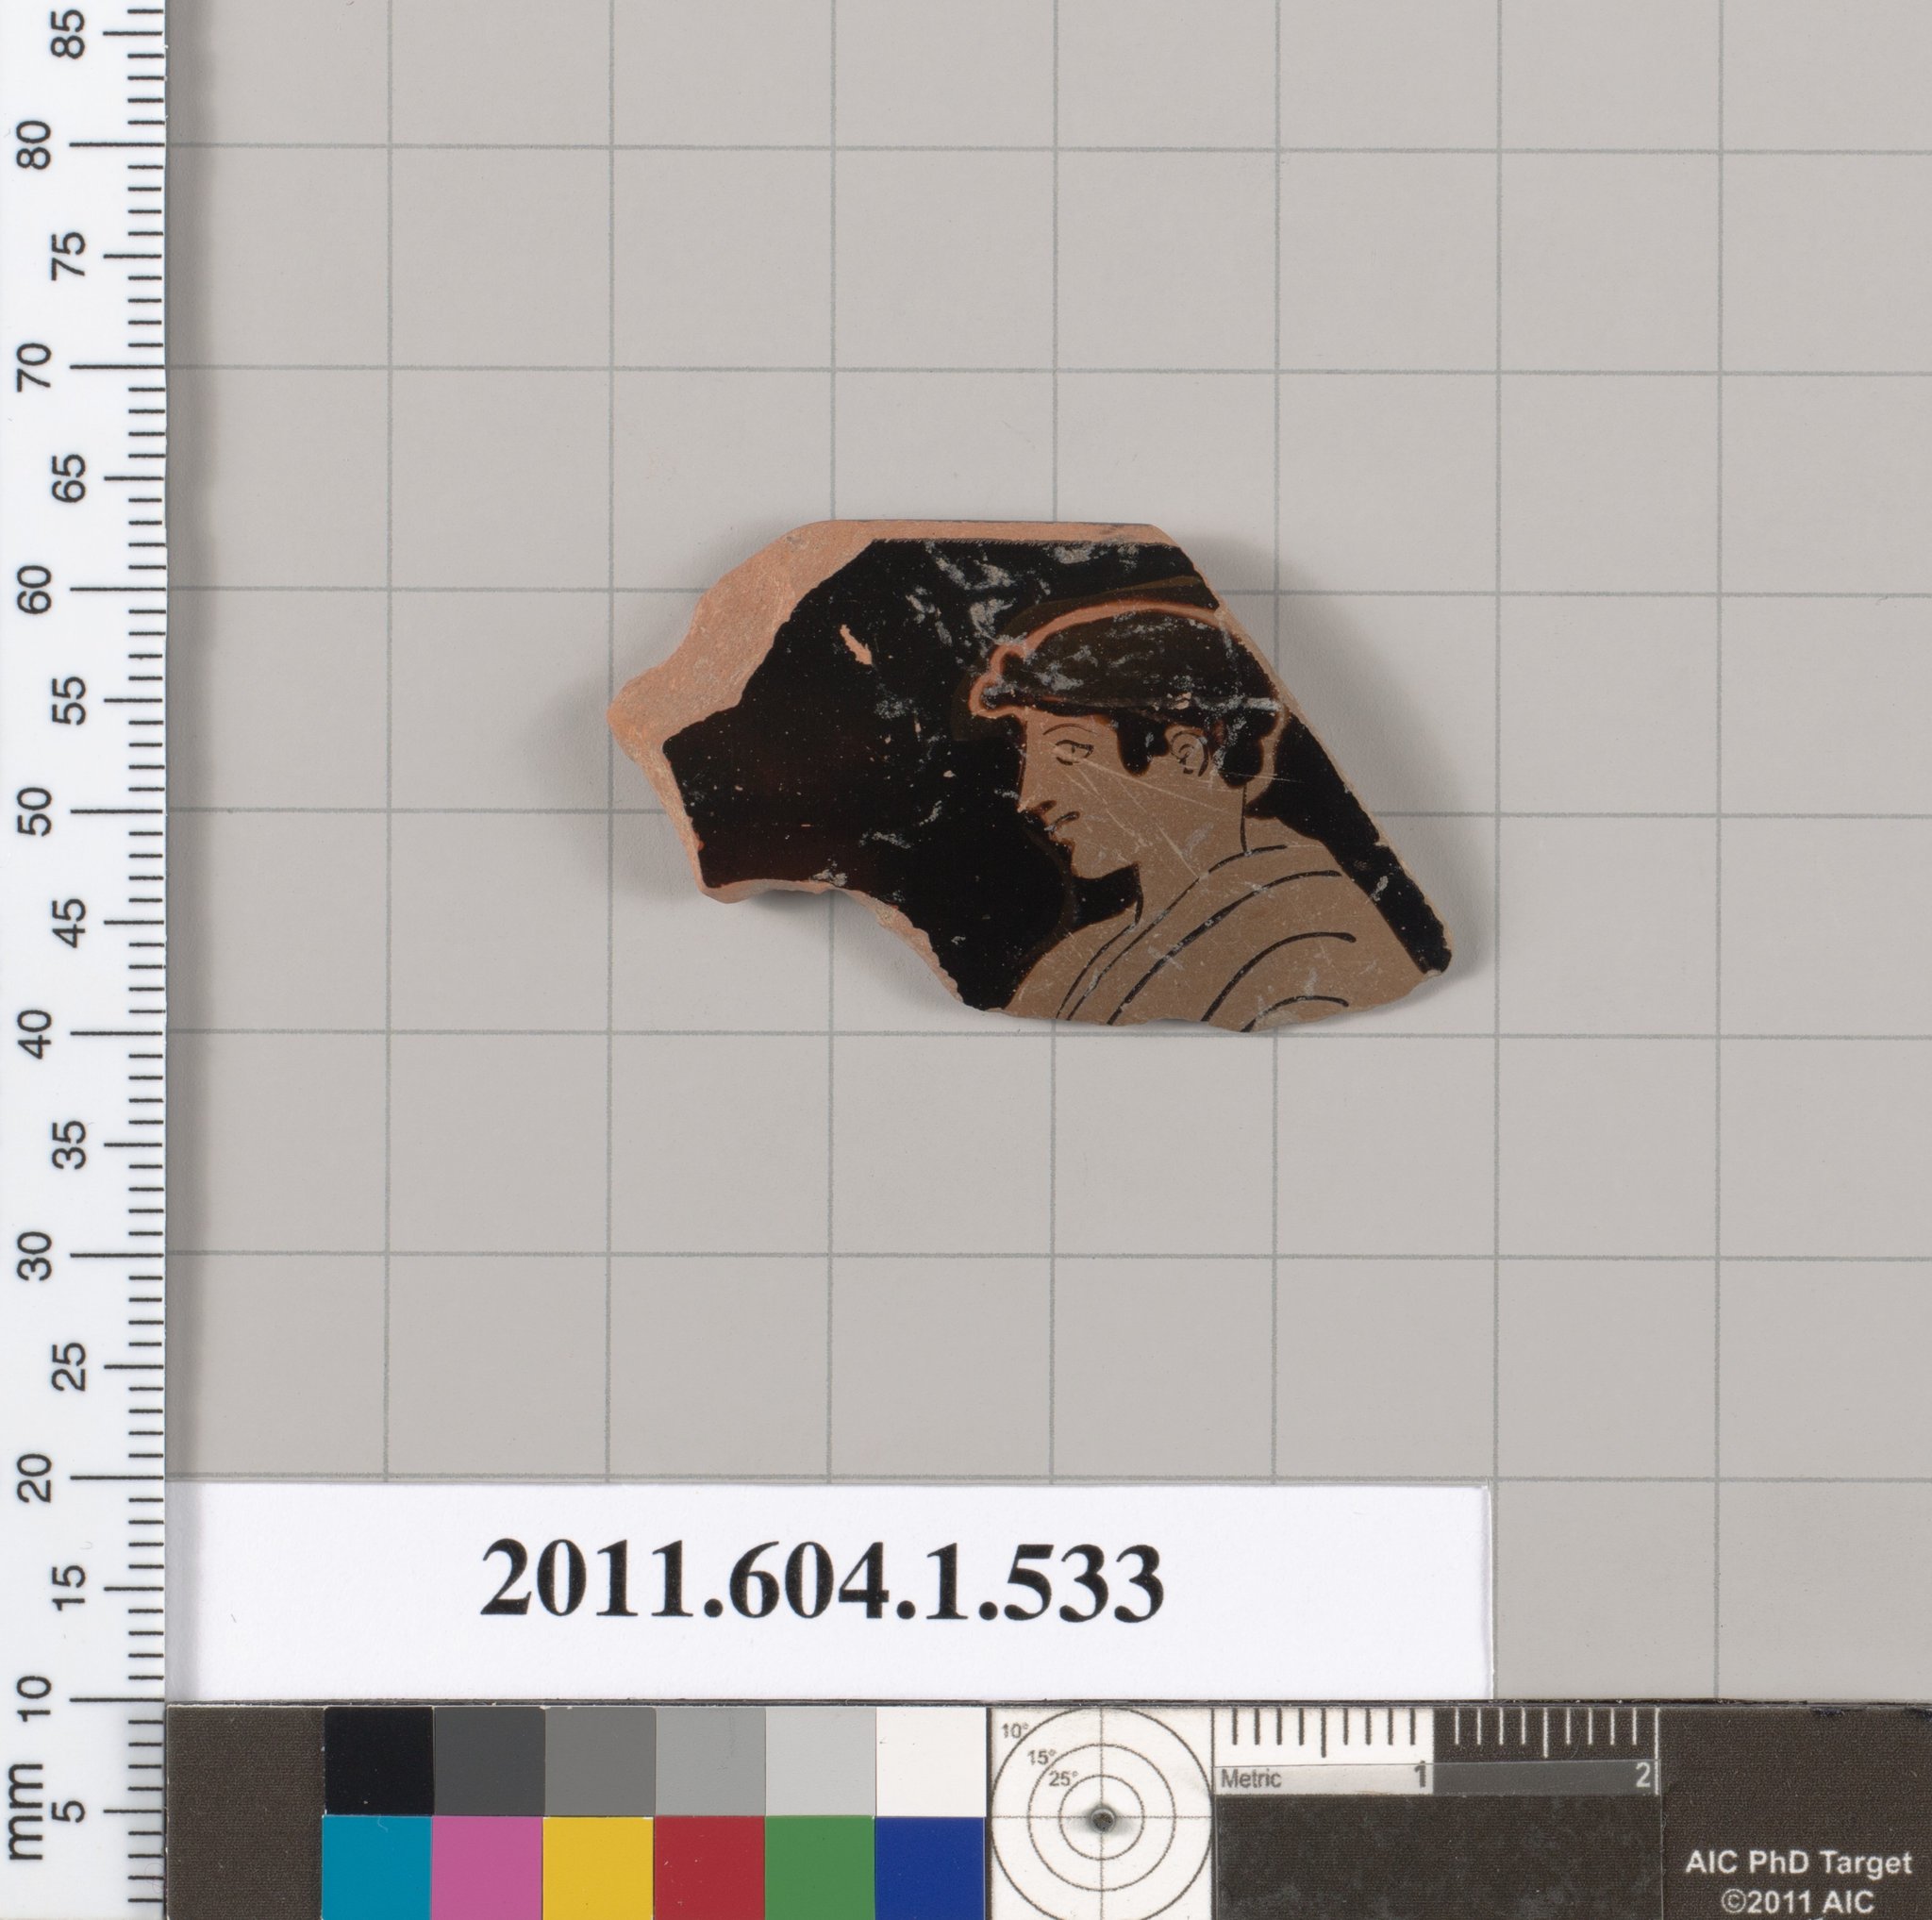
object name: kylix fragment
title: Terracotta rim fragment of a kylix (drinking cup)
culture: greek, attic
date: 480-470 BCE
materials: terracotta